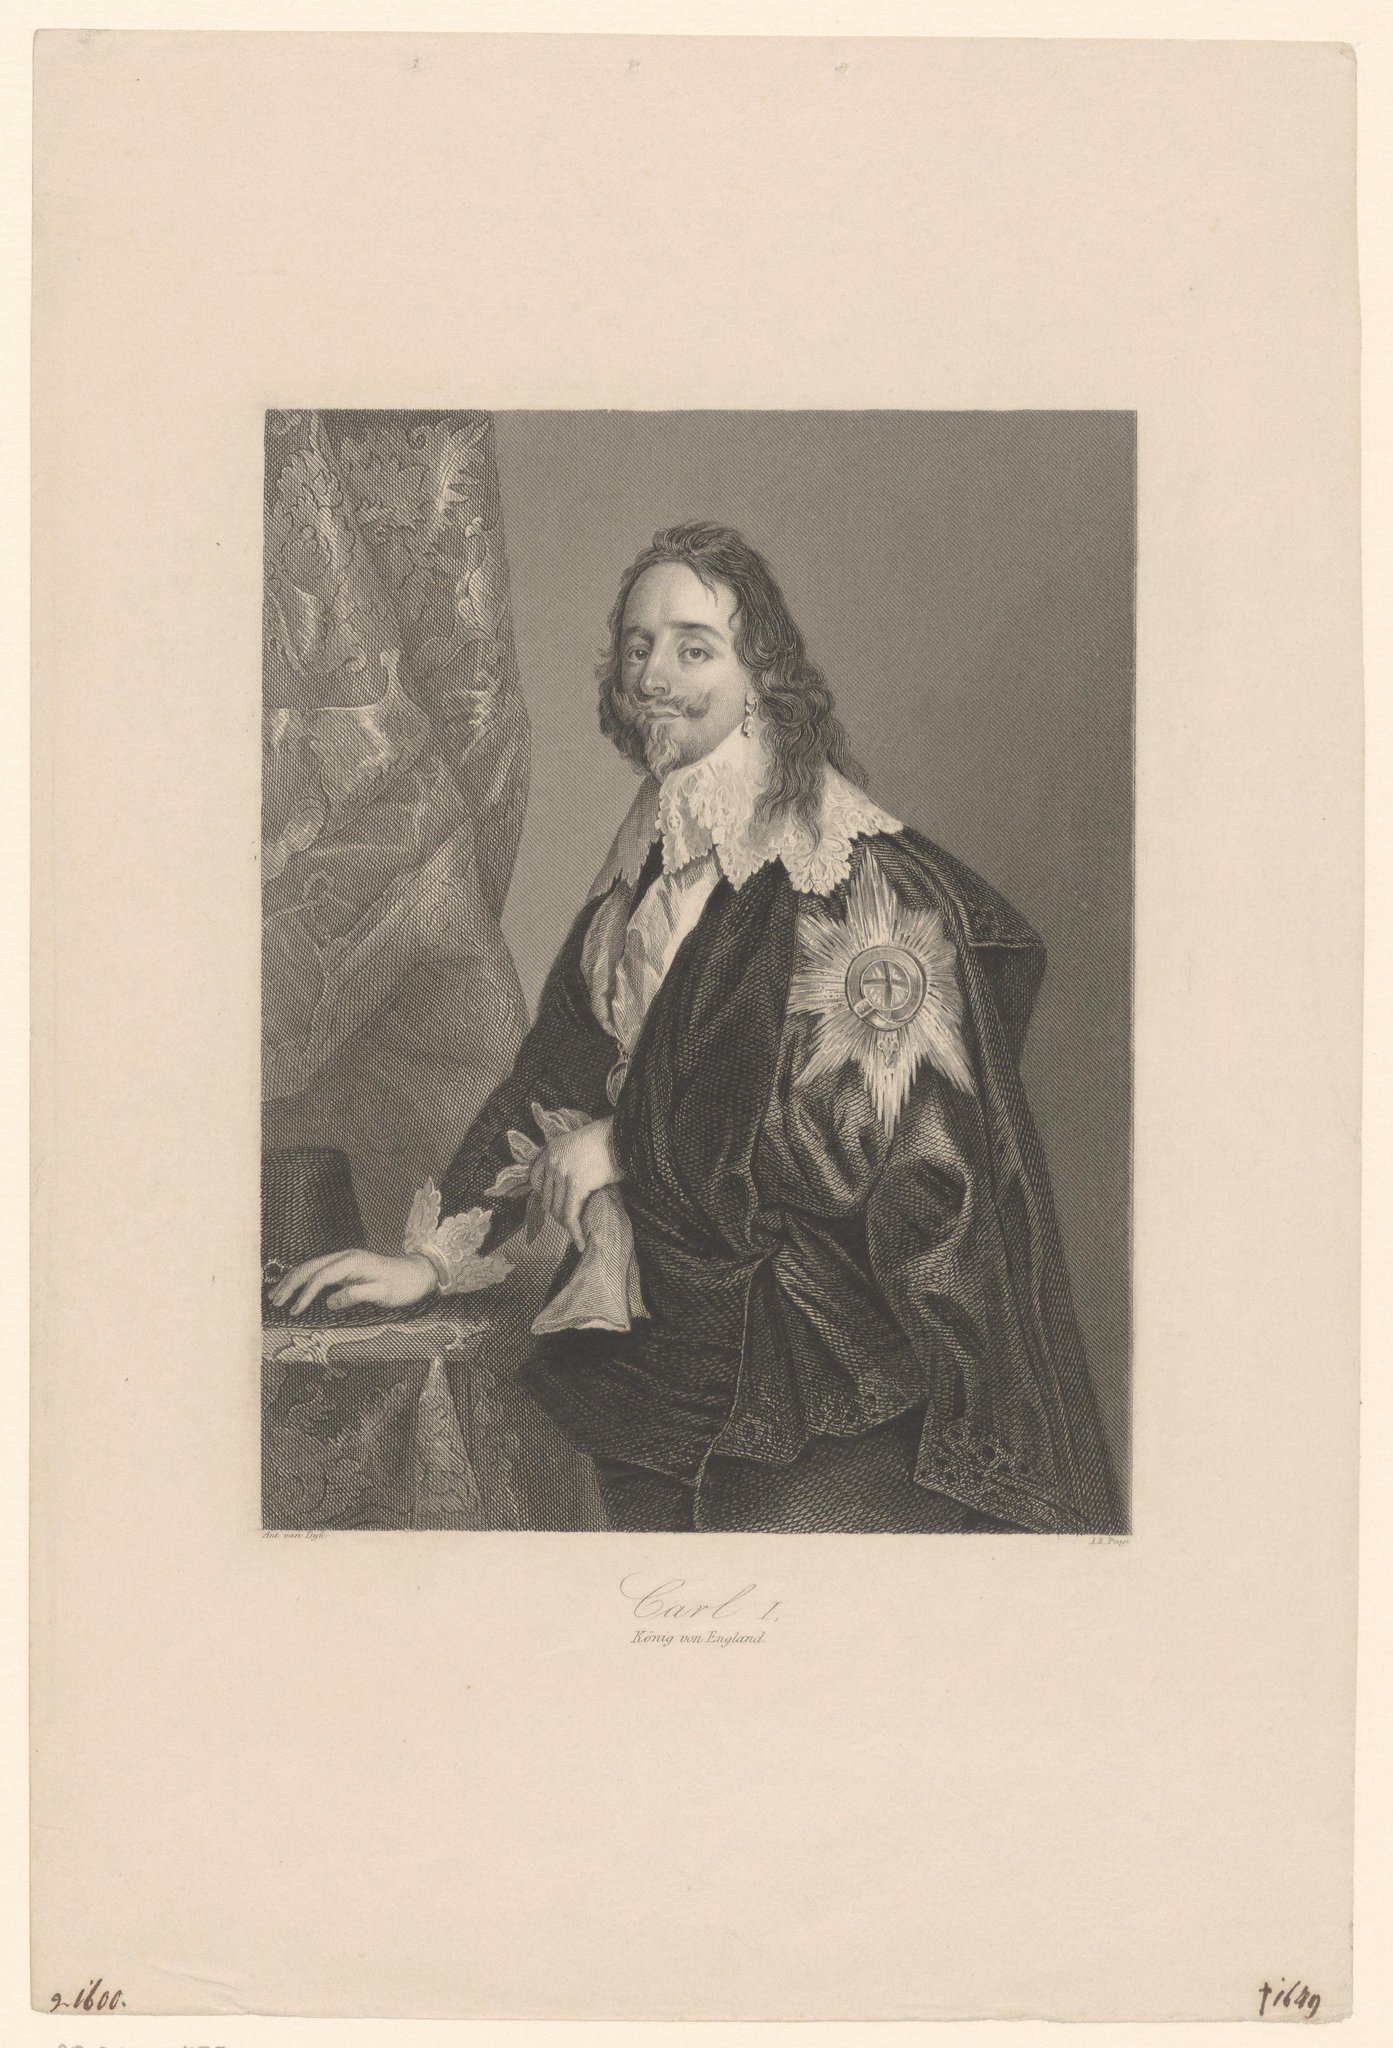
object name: print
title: Portret van Karel I van Engeland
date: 1845-1902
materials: paper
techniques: etching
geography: leipzig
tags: karel i (koning van engeland), historical persons, king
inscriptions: collector's mark: Lugt 2228